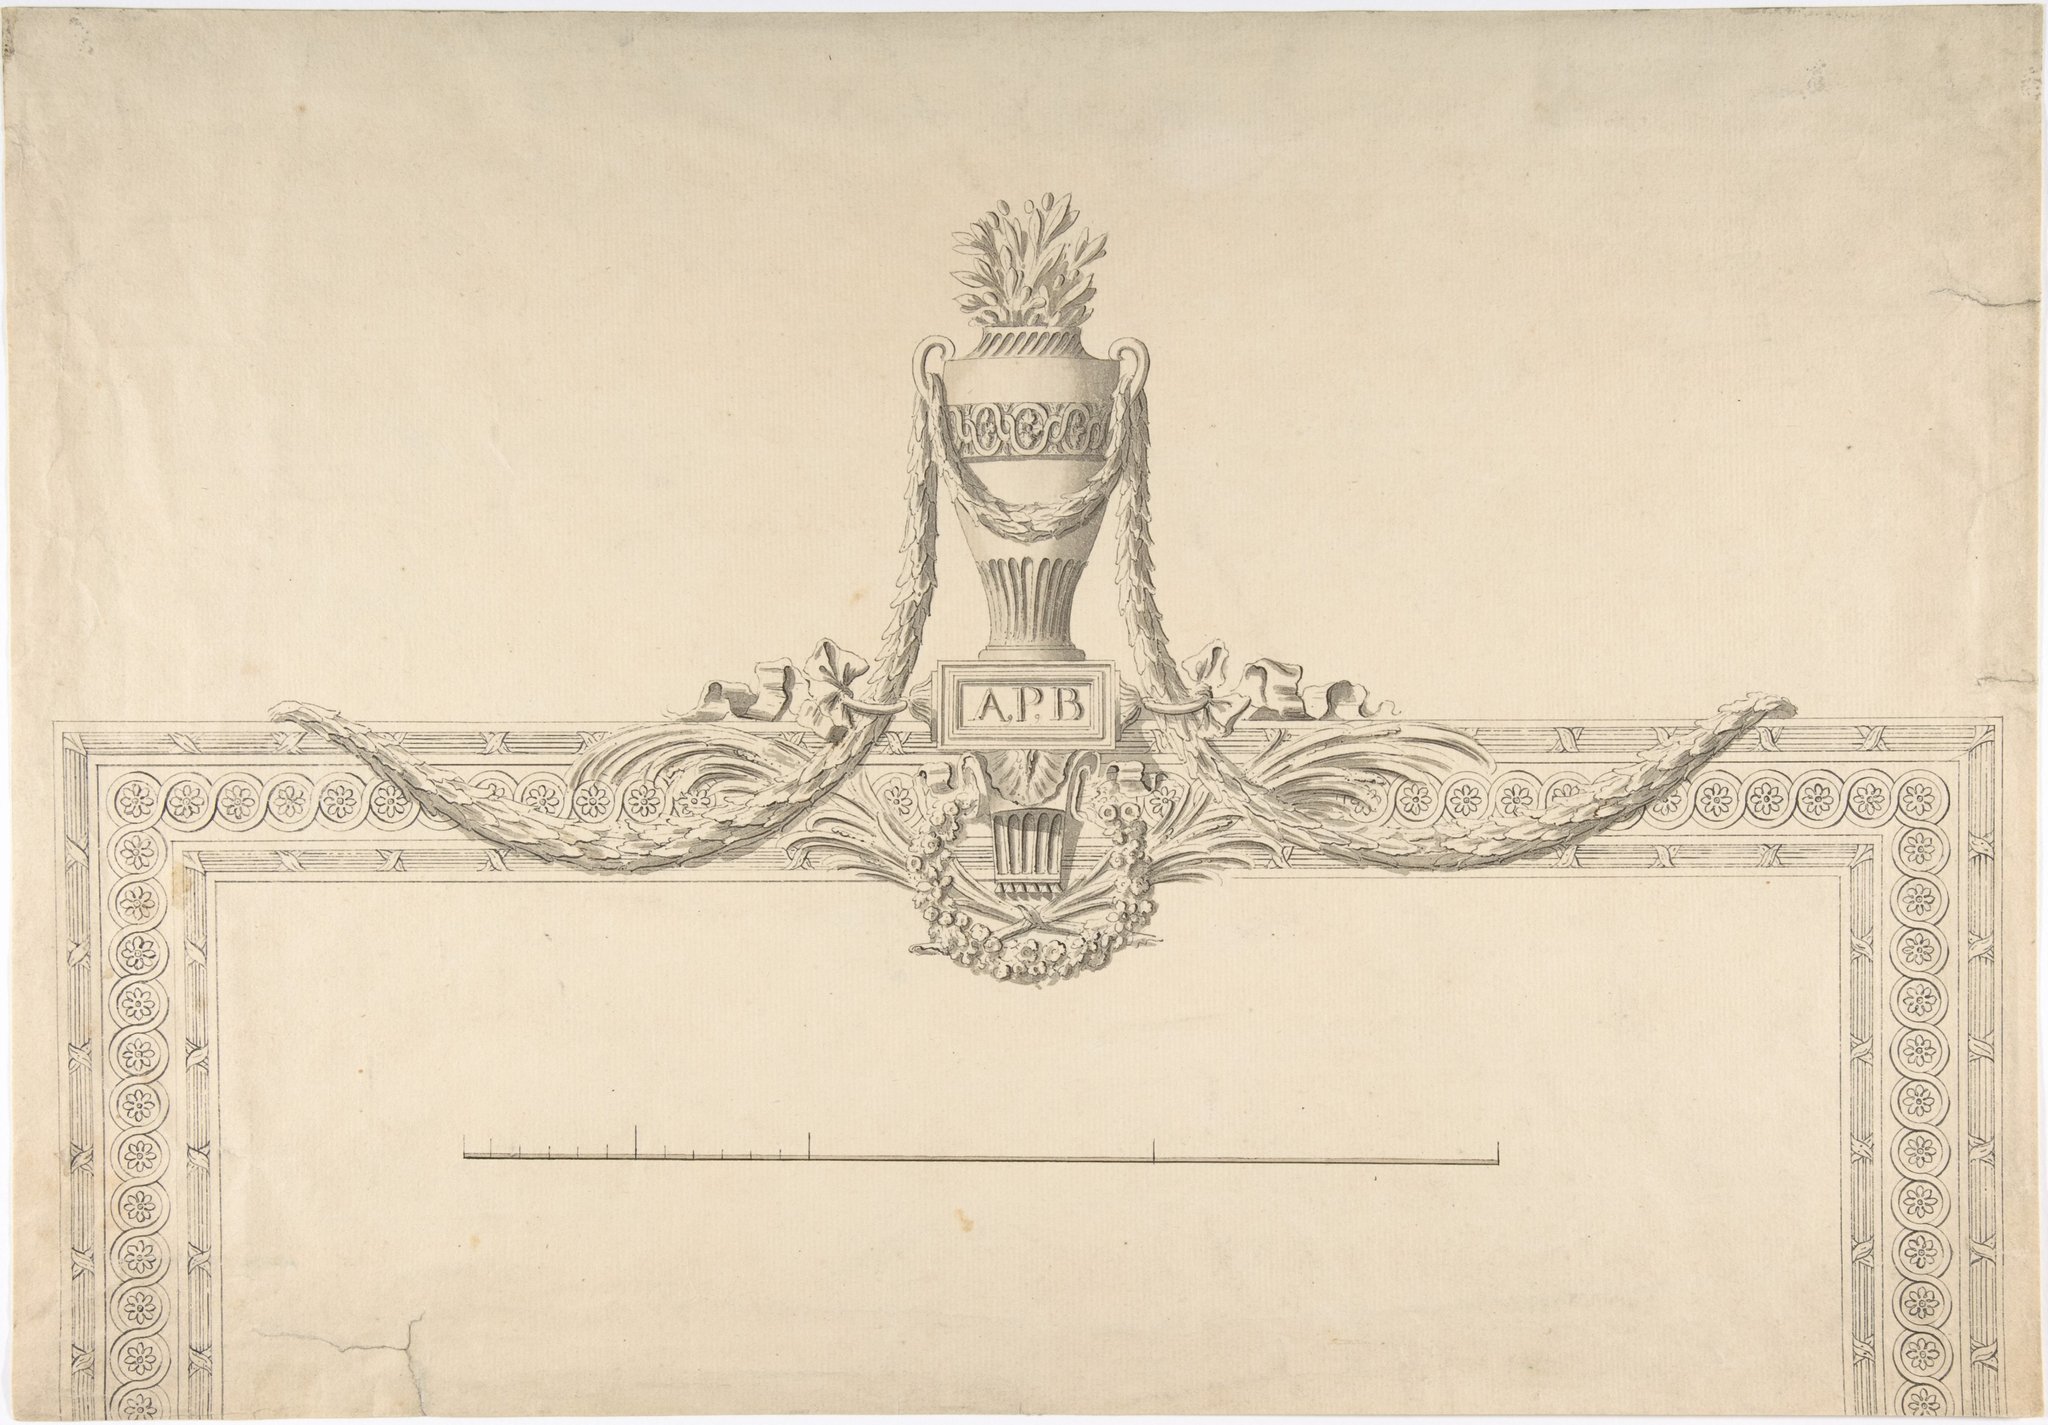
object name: drawing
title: Design for Mirror Frame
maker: anonymous, french, 18th century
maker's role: artist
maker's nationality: french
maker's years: 1700-1800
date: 1770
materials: ink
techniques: brush, pen, wash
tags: flowers,leaves